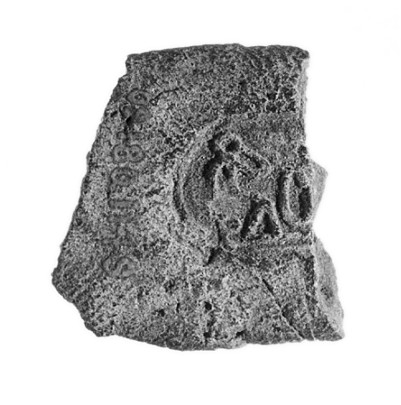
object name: sealing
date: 1981-1640 BCE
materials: clay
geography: egypt